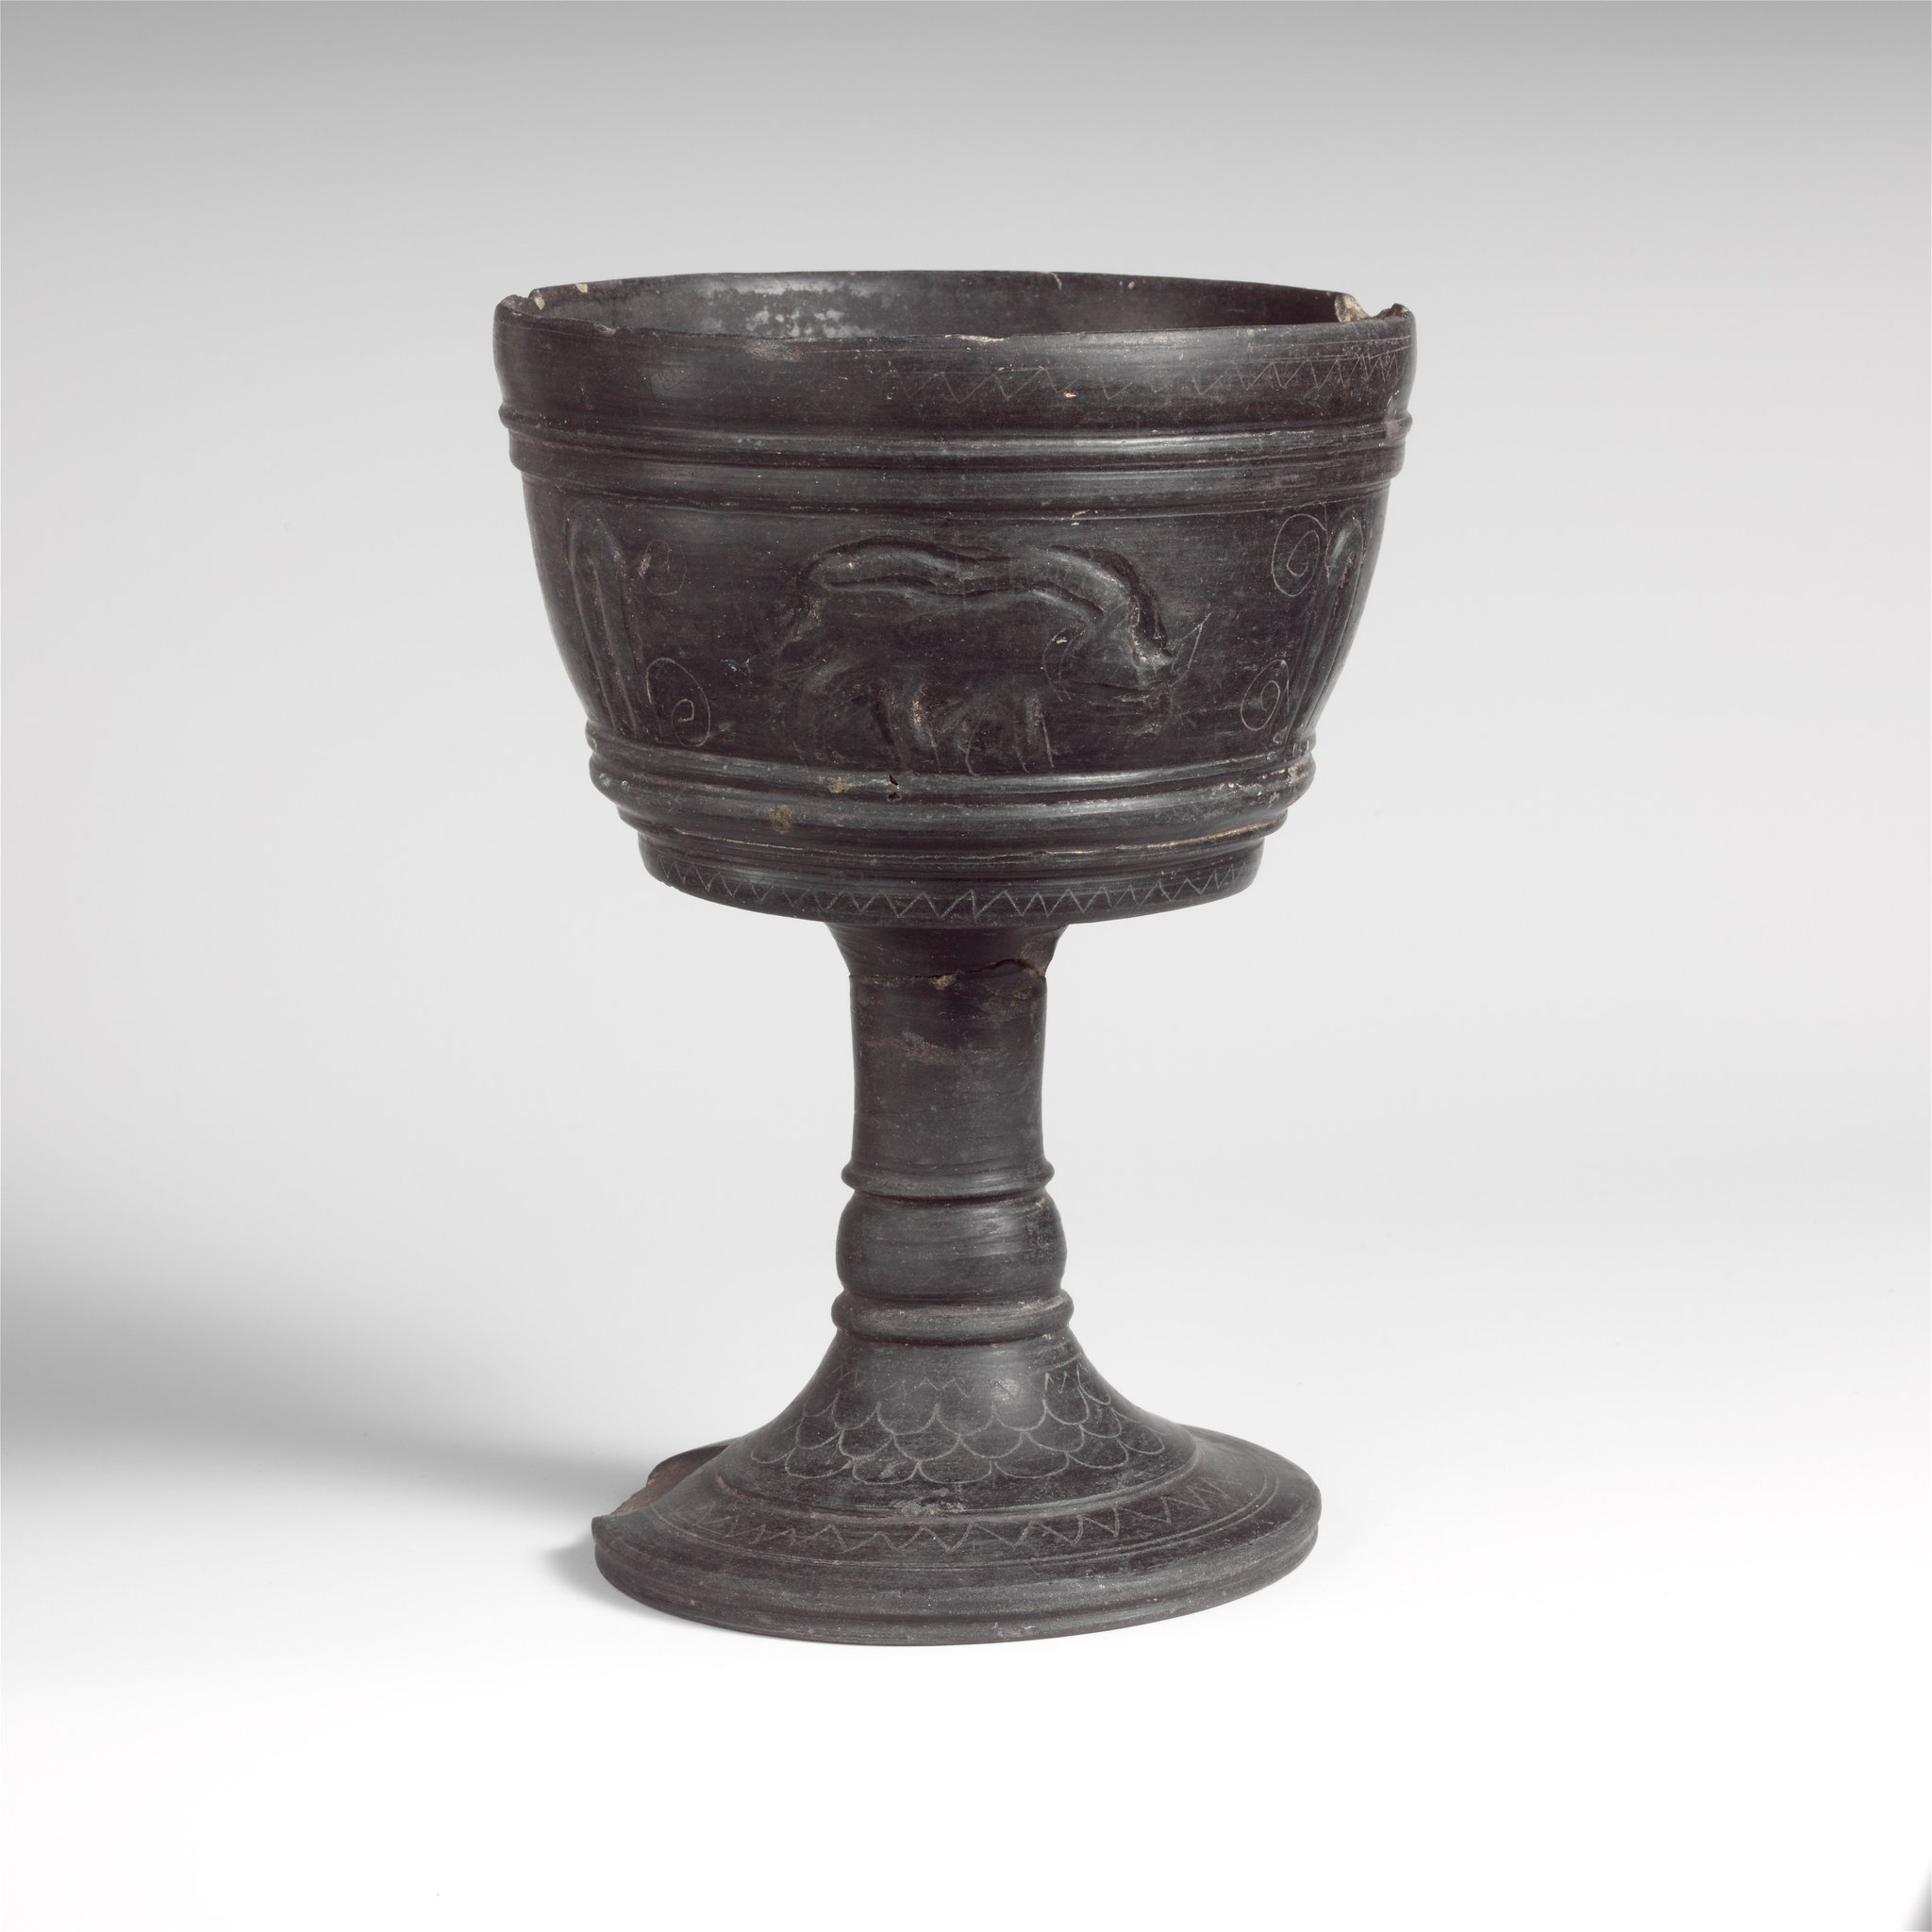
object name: cup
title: Terracotta footed cup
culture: etruscan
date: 550 BCE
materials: terracotta